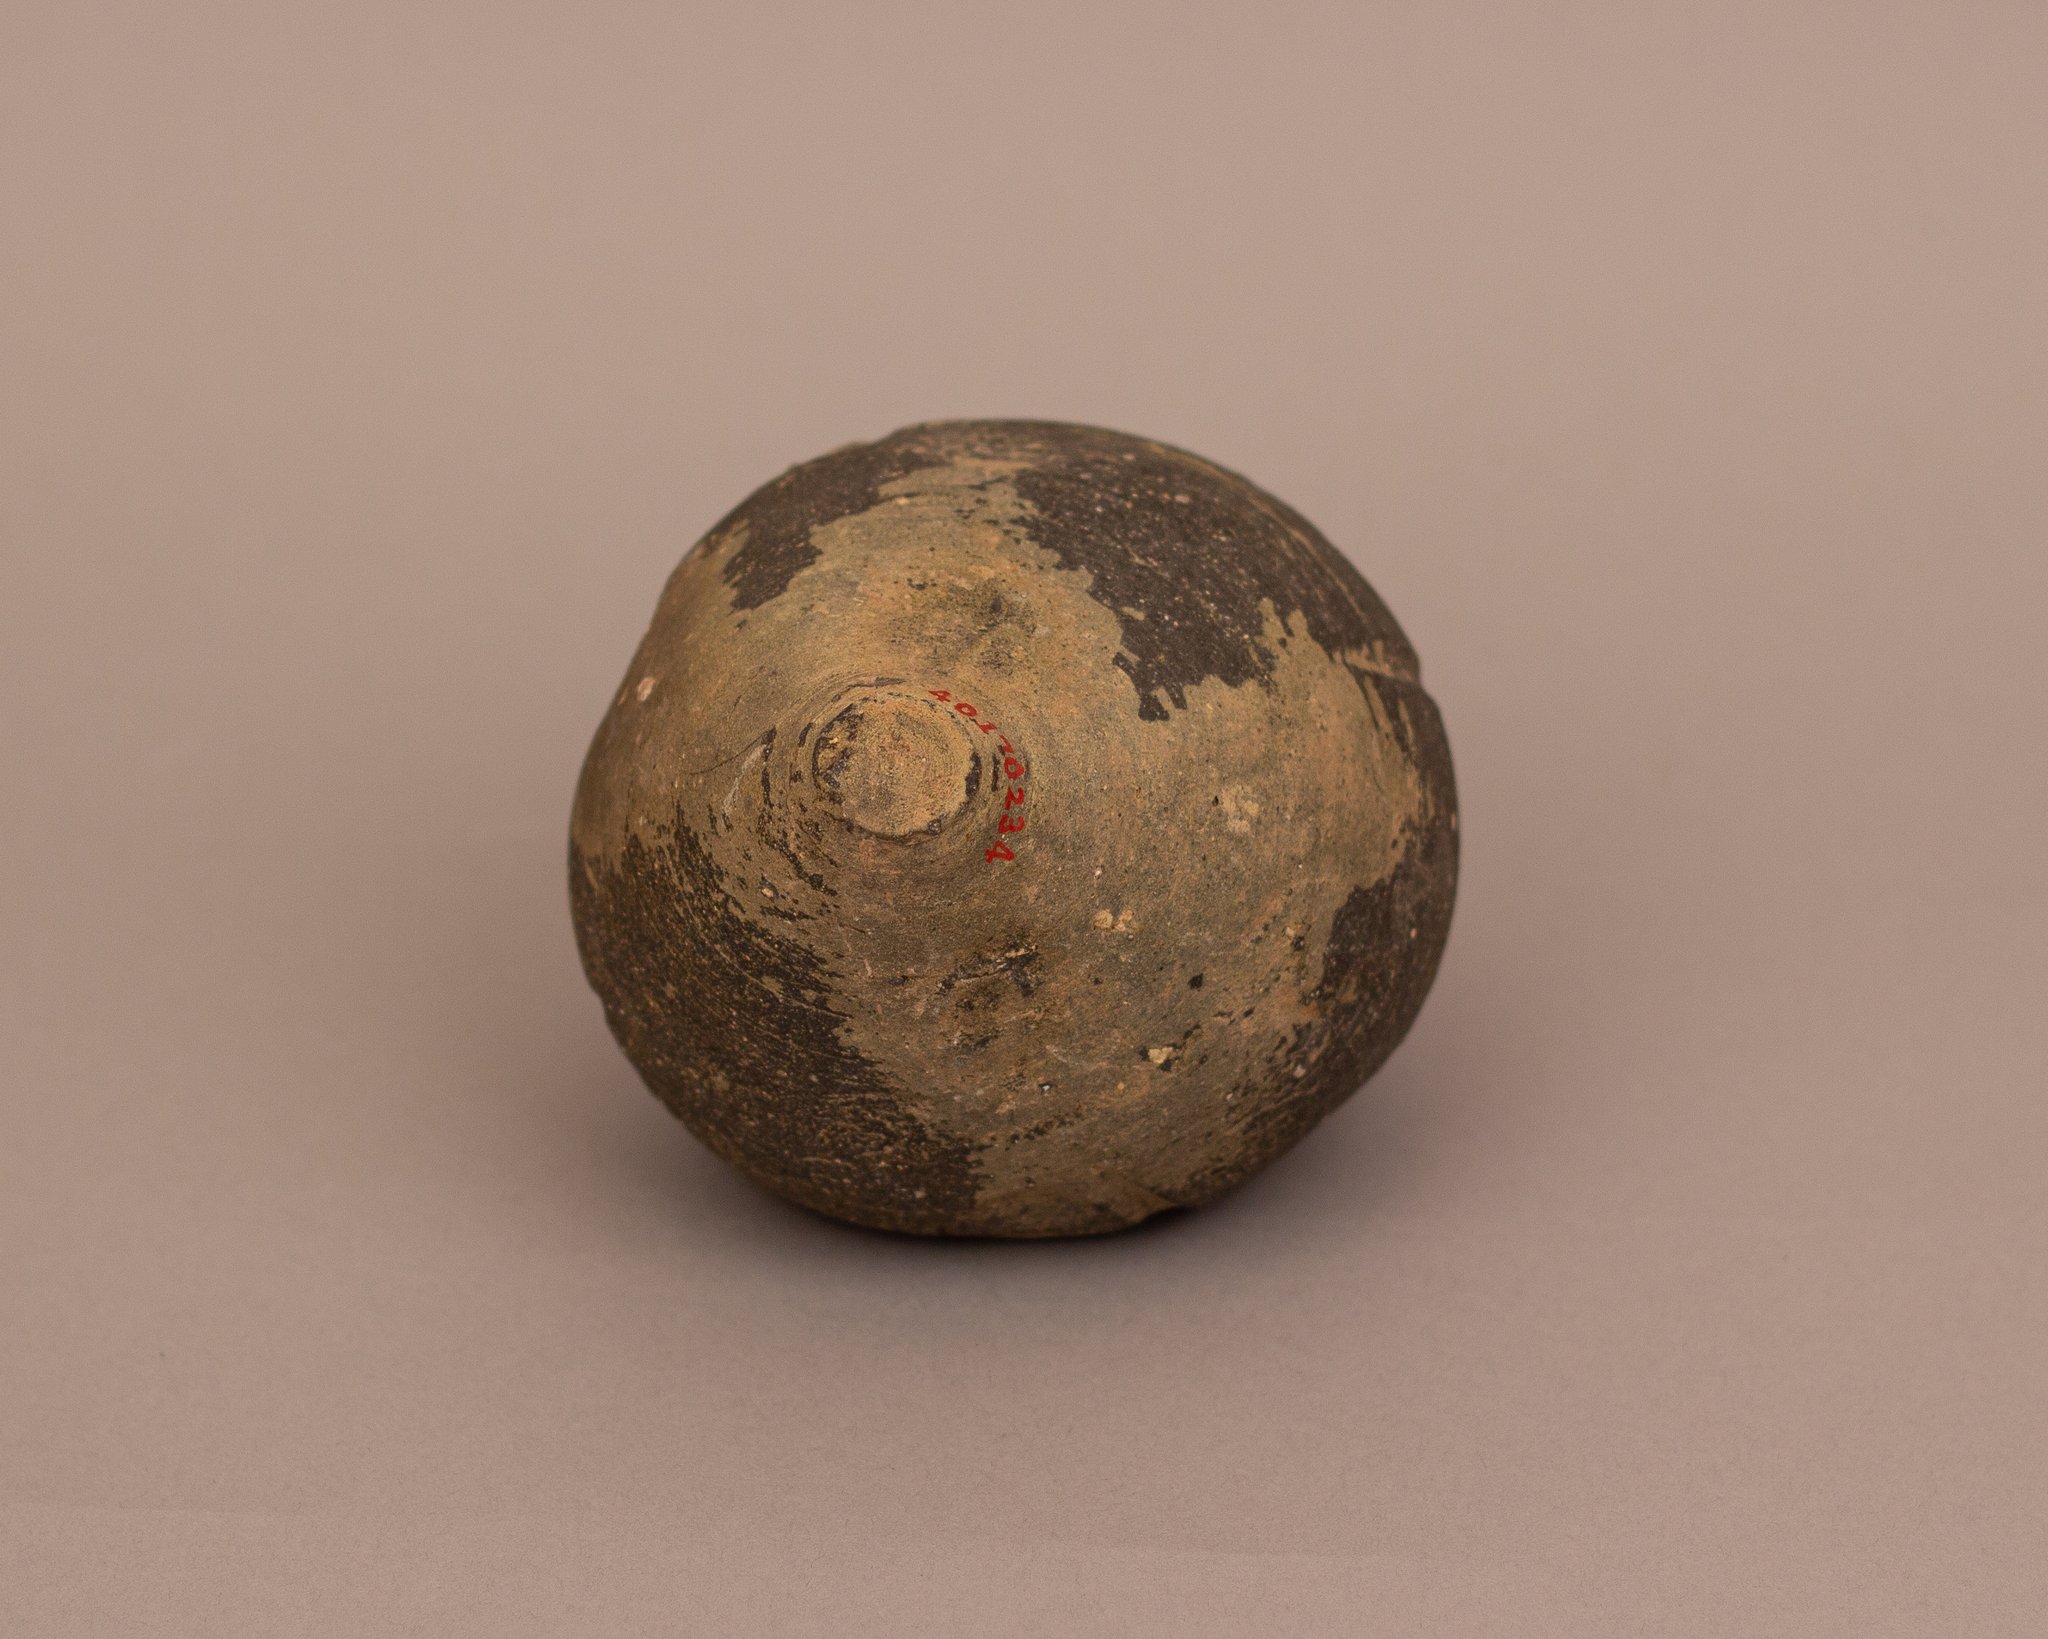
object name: spheroconical vessel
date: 801-1000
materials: earthenware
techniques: incising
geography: iran